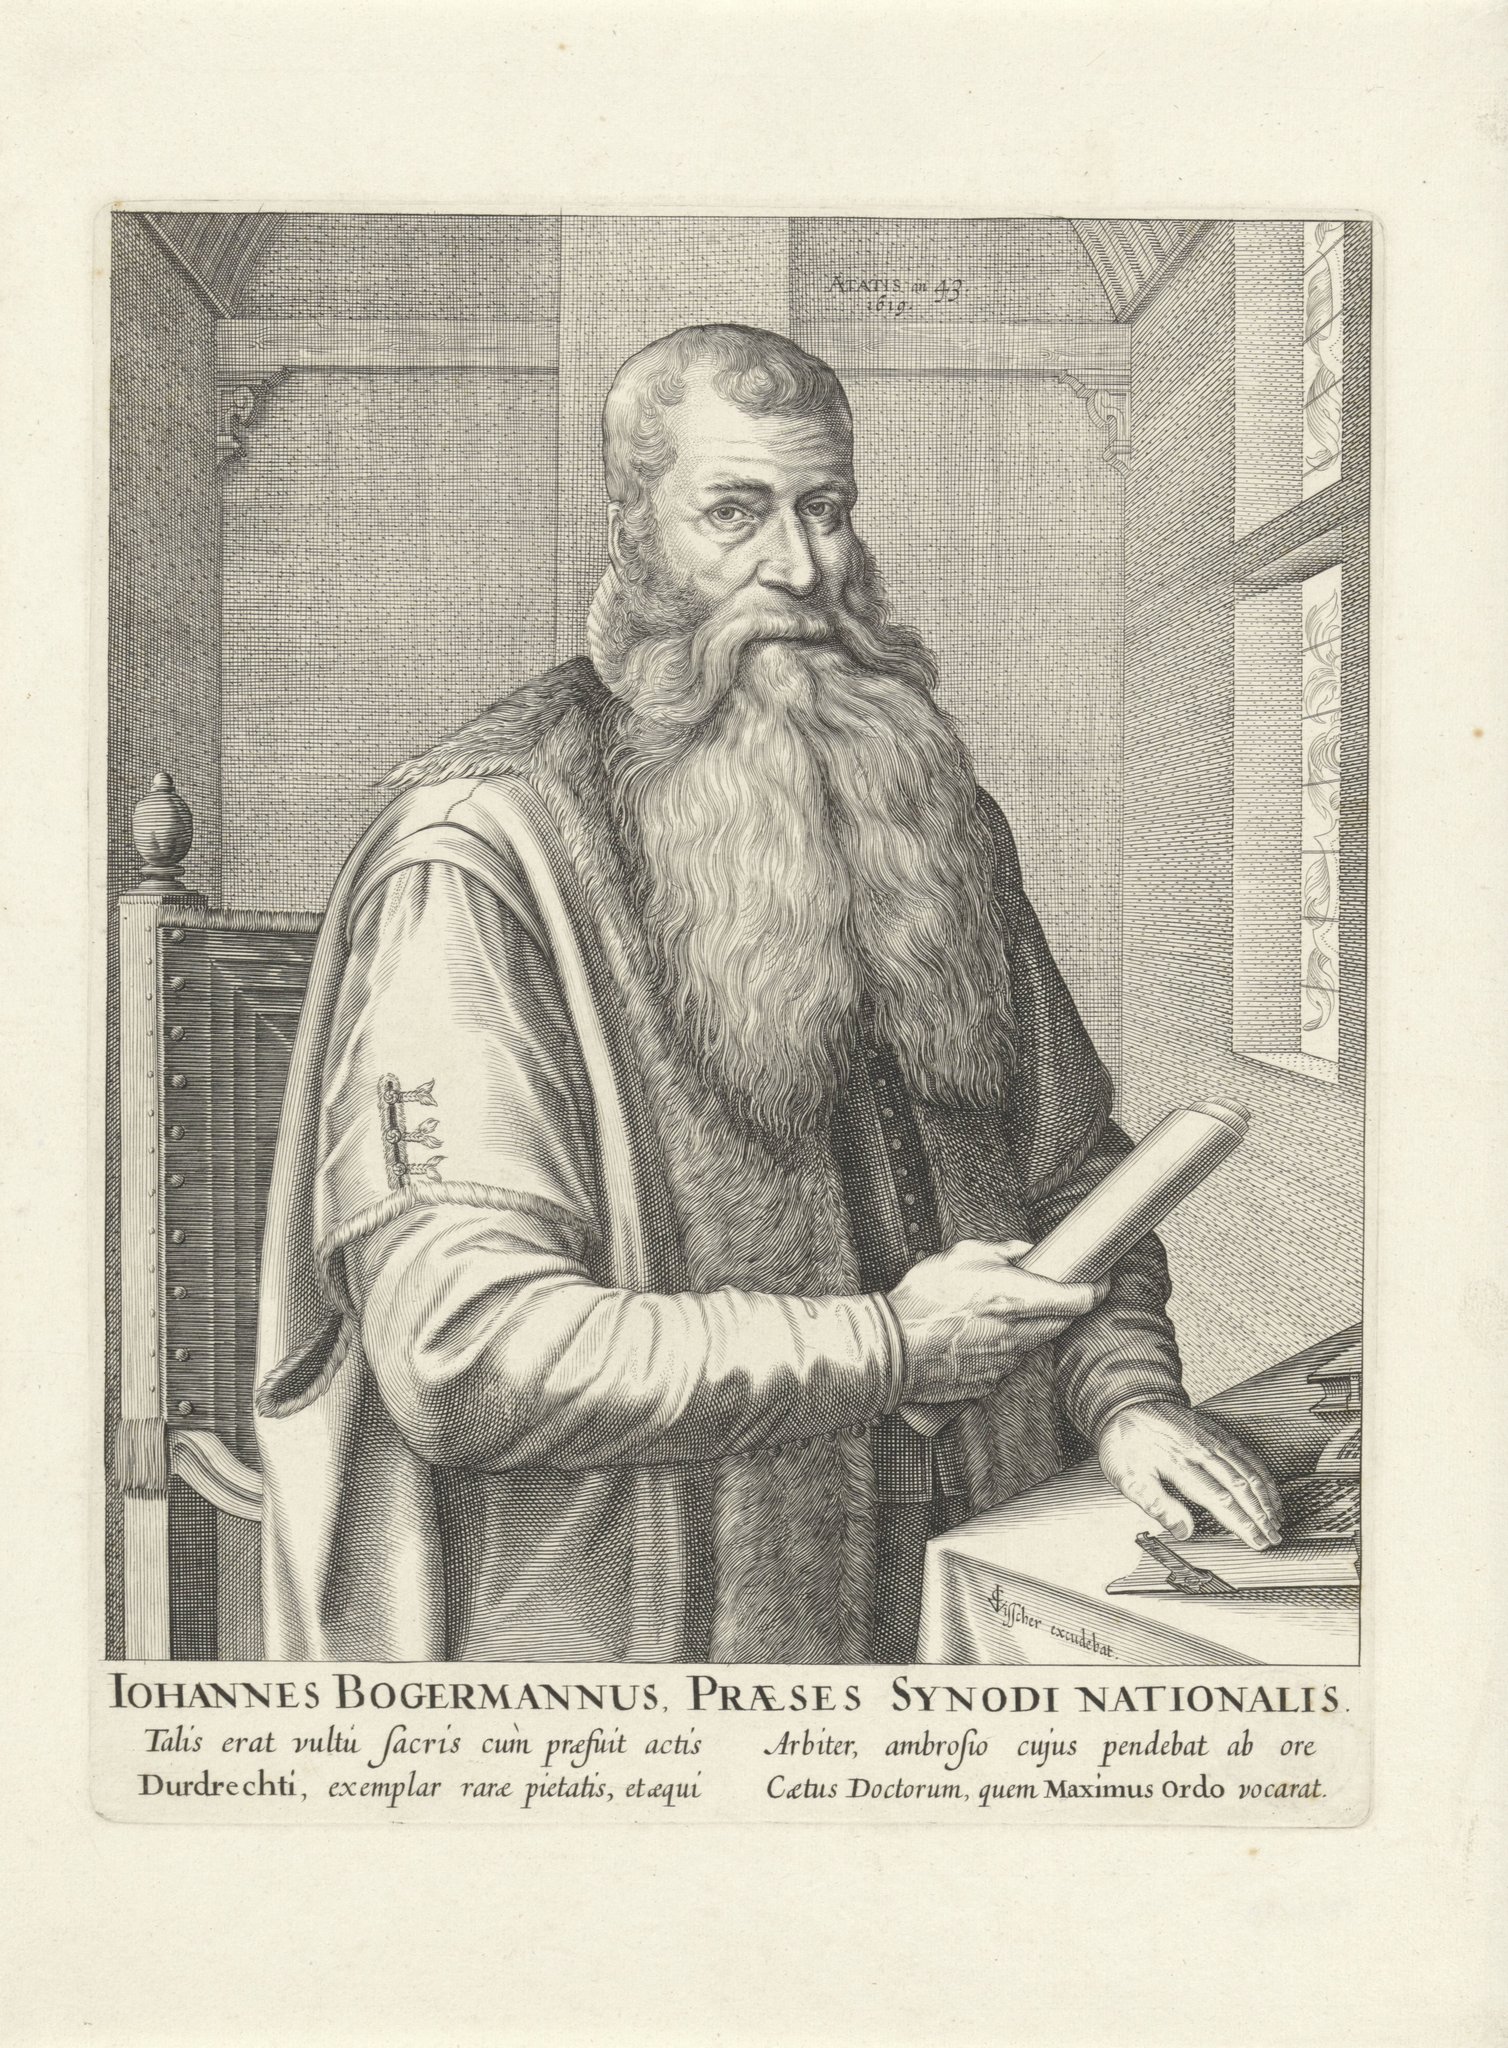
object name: print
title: Portret van Johannes Bogerman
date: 1619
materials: paper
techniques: engraving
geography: amsterdam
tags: book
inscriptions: collector's mark: Lugt 240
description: De predikant Johannes Bogerman op 43-jarige leeftijd. Hij staat in een kamer, achter een tafel. In zijn rechter hand heeft hij een schriftrol en zijn linker hand ligt op een opengeslagen boek. Hij was voorzitter van de nationale synode te Dordrecht in 1618-1619.